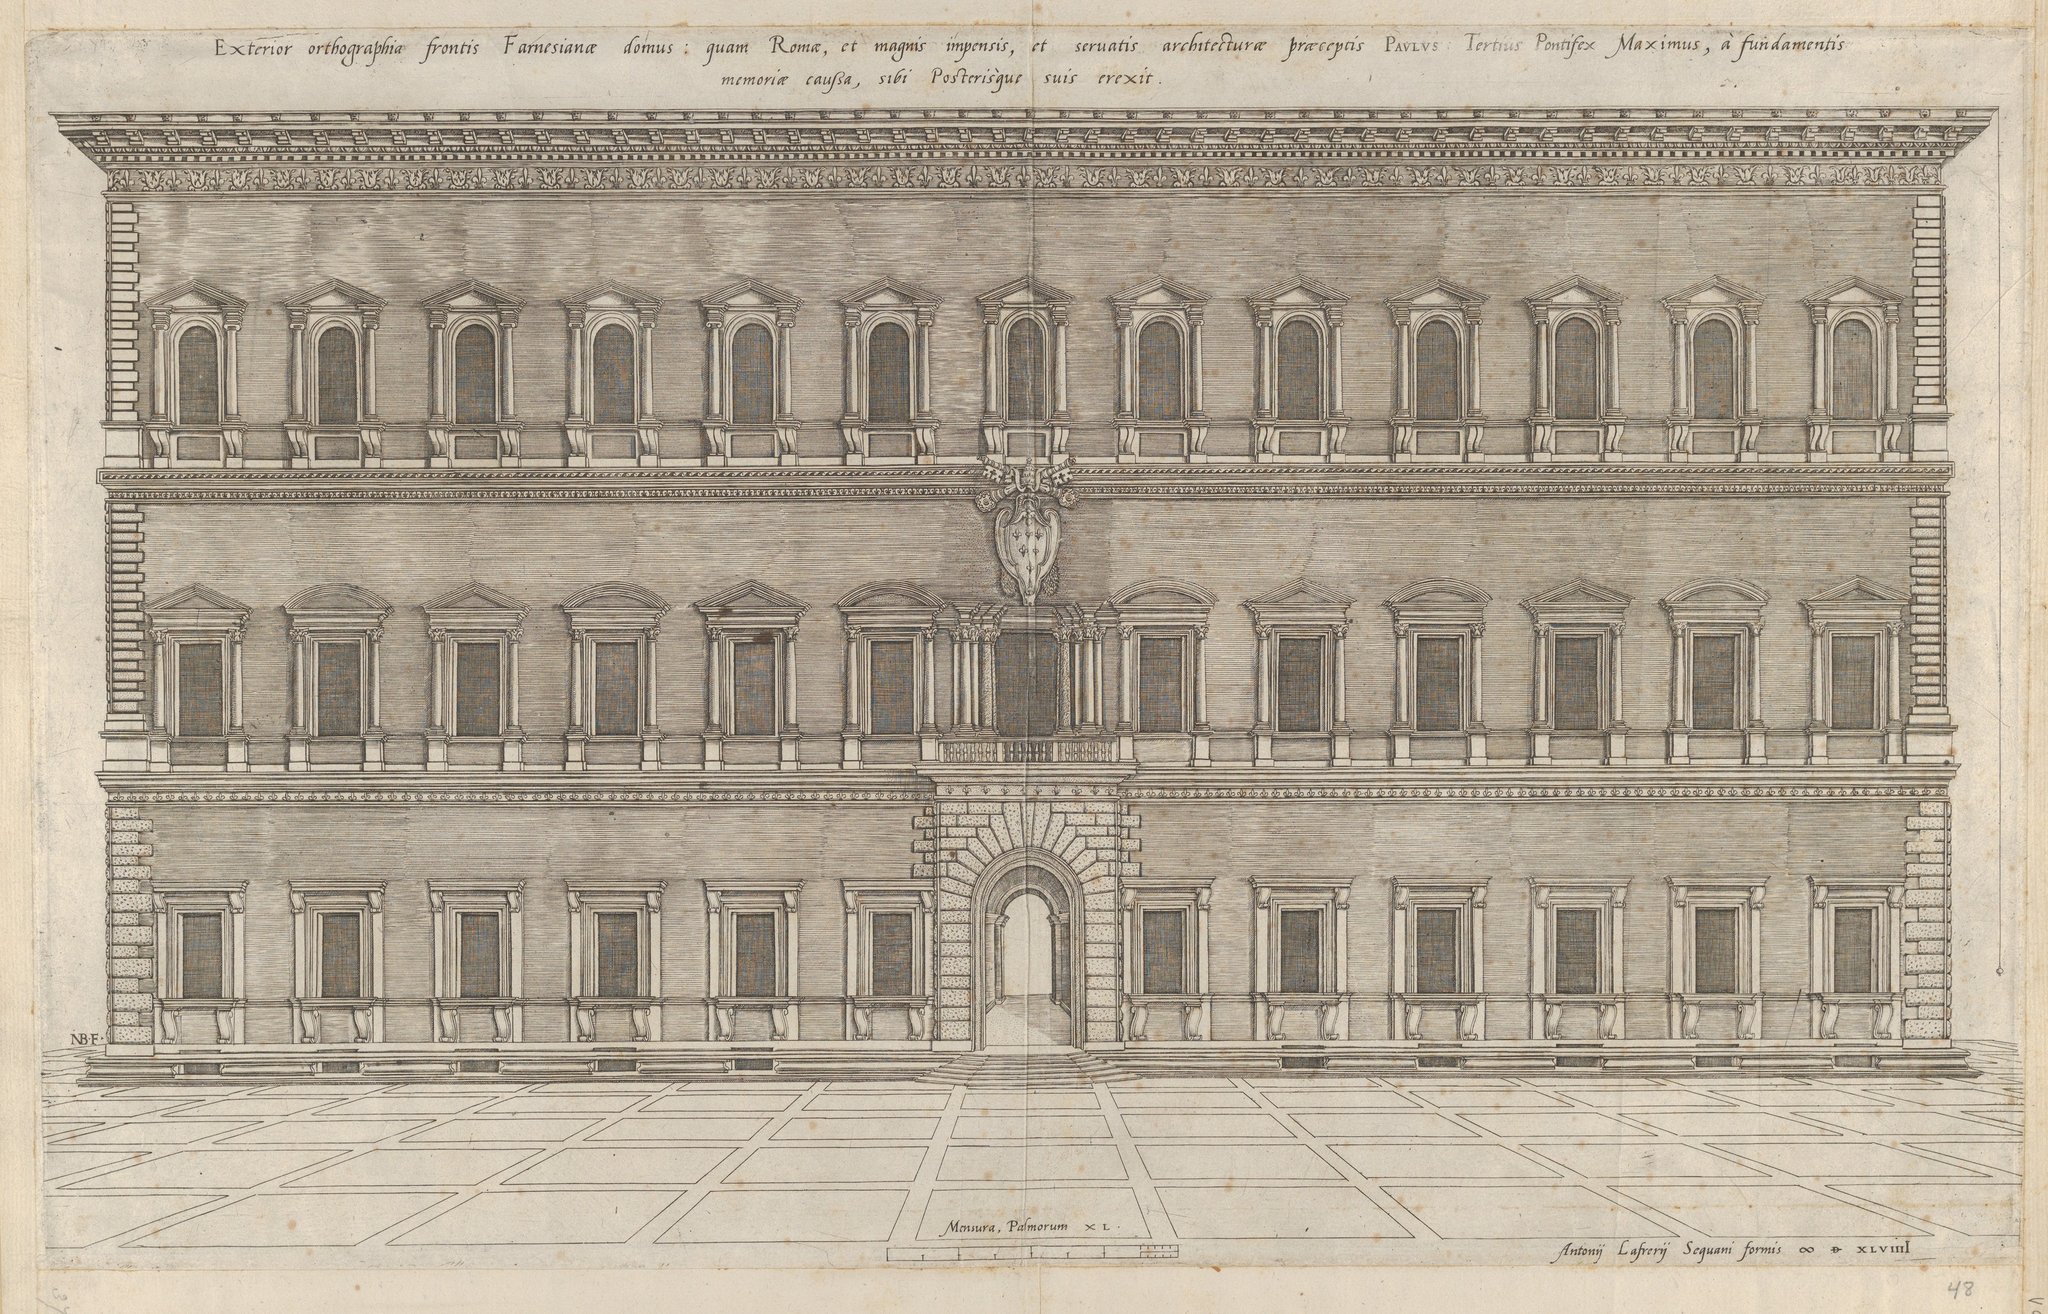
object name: print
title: Exterior of the Farnese Palace, from "Speculum Romanae Magnificentiae"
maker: nicolas beatrizet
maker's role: artist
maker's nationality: french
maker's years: 1515-1566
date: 1549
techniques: engraving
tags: palaces,rome